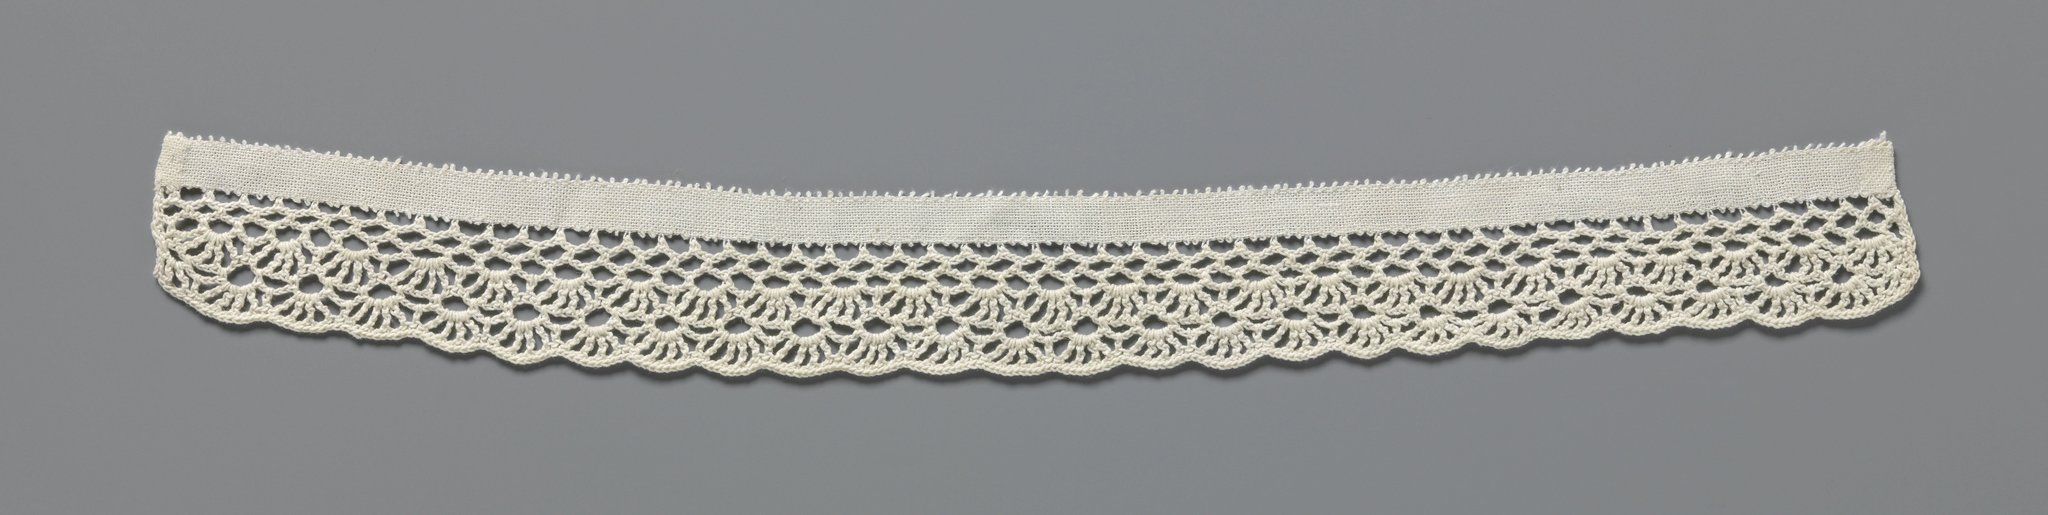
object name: collar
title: Kraag van haakwerk met ruit- en waaiermotief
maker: Anonymous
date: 1930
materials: cotton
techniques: crochet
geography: western europe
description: Smalle rechte kraag van naturelkleurig haakwerk. Drie rijen met ruitjes , gemaakt met lossen. Daaronder twee rijen met waaiertjes, gemaakt met gehaakte stokjes. De waaiertjes vormen een golvende rand aan de onderzijde. De bovenzijde is afgezet met een geweven rand.